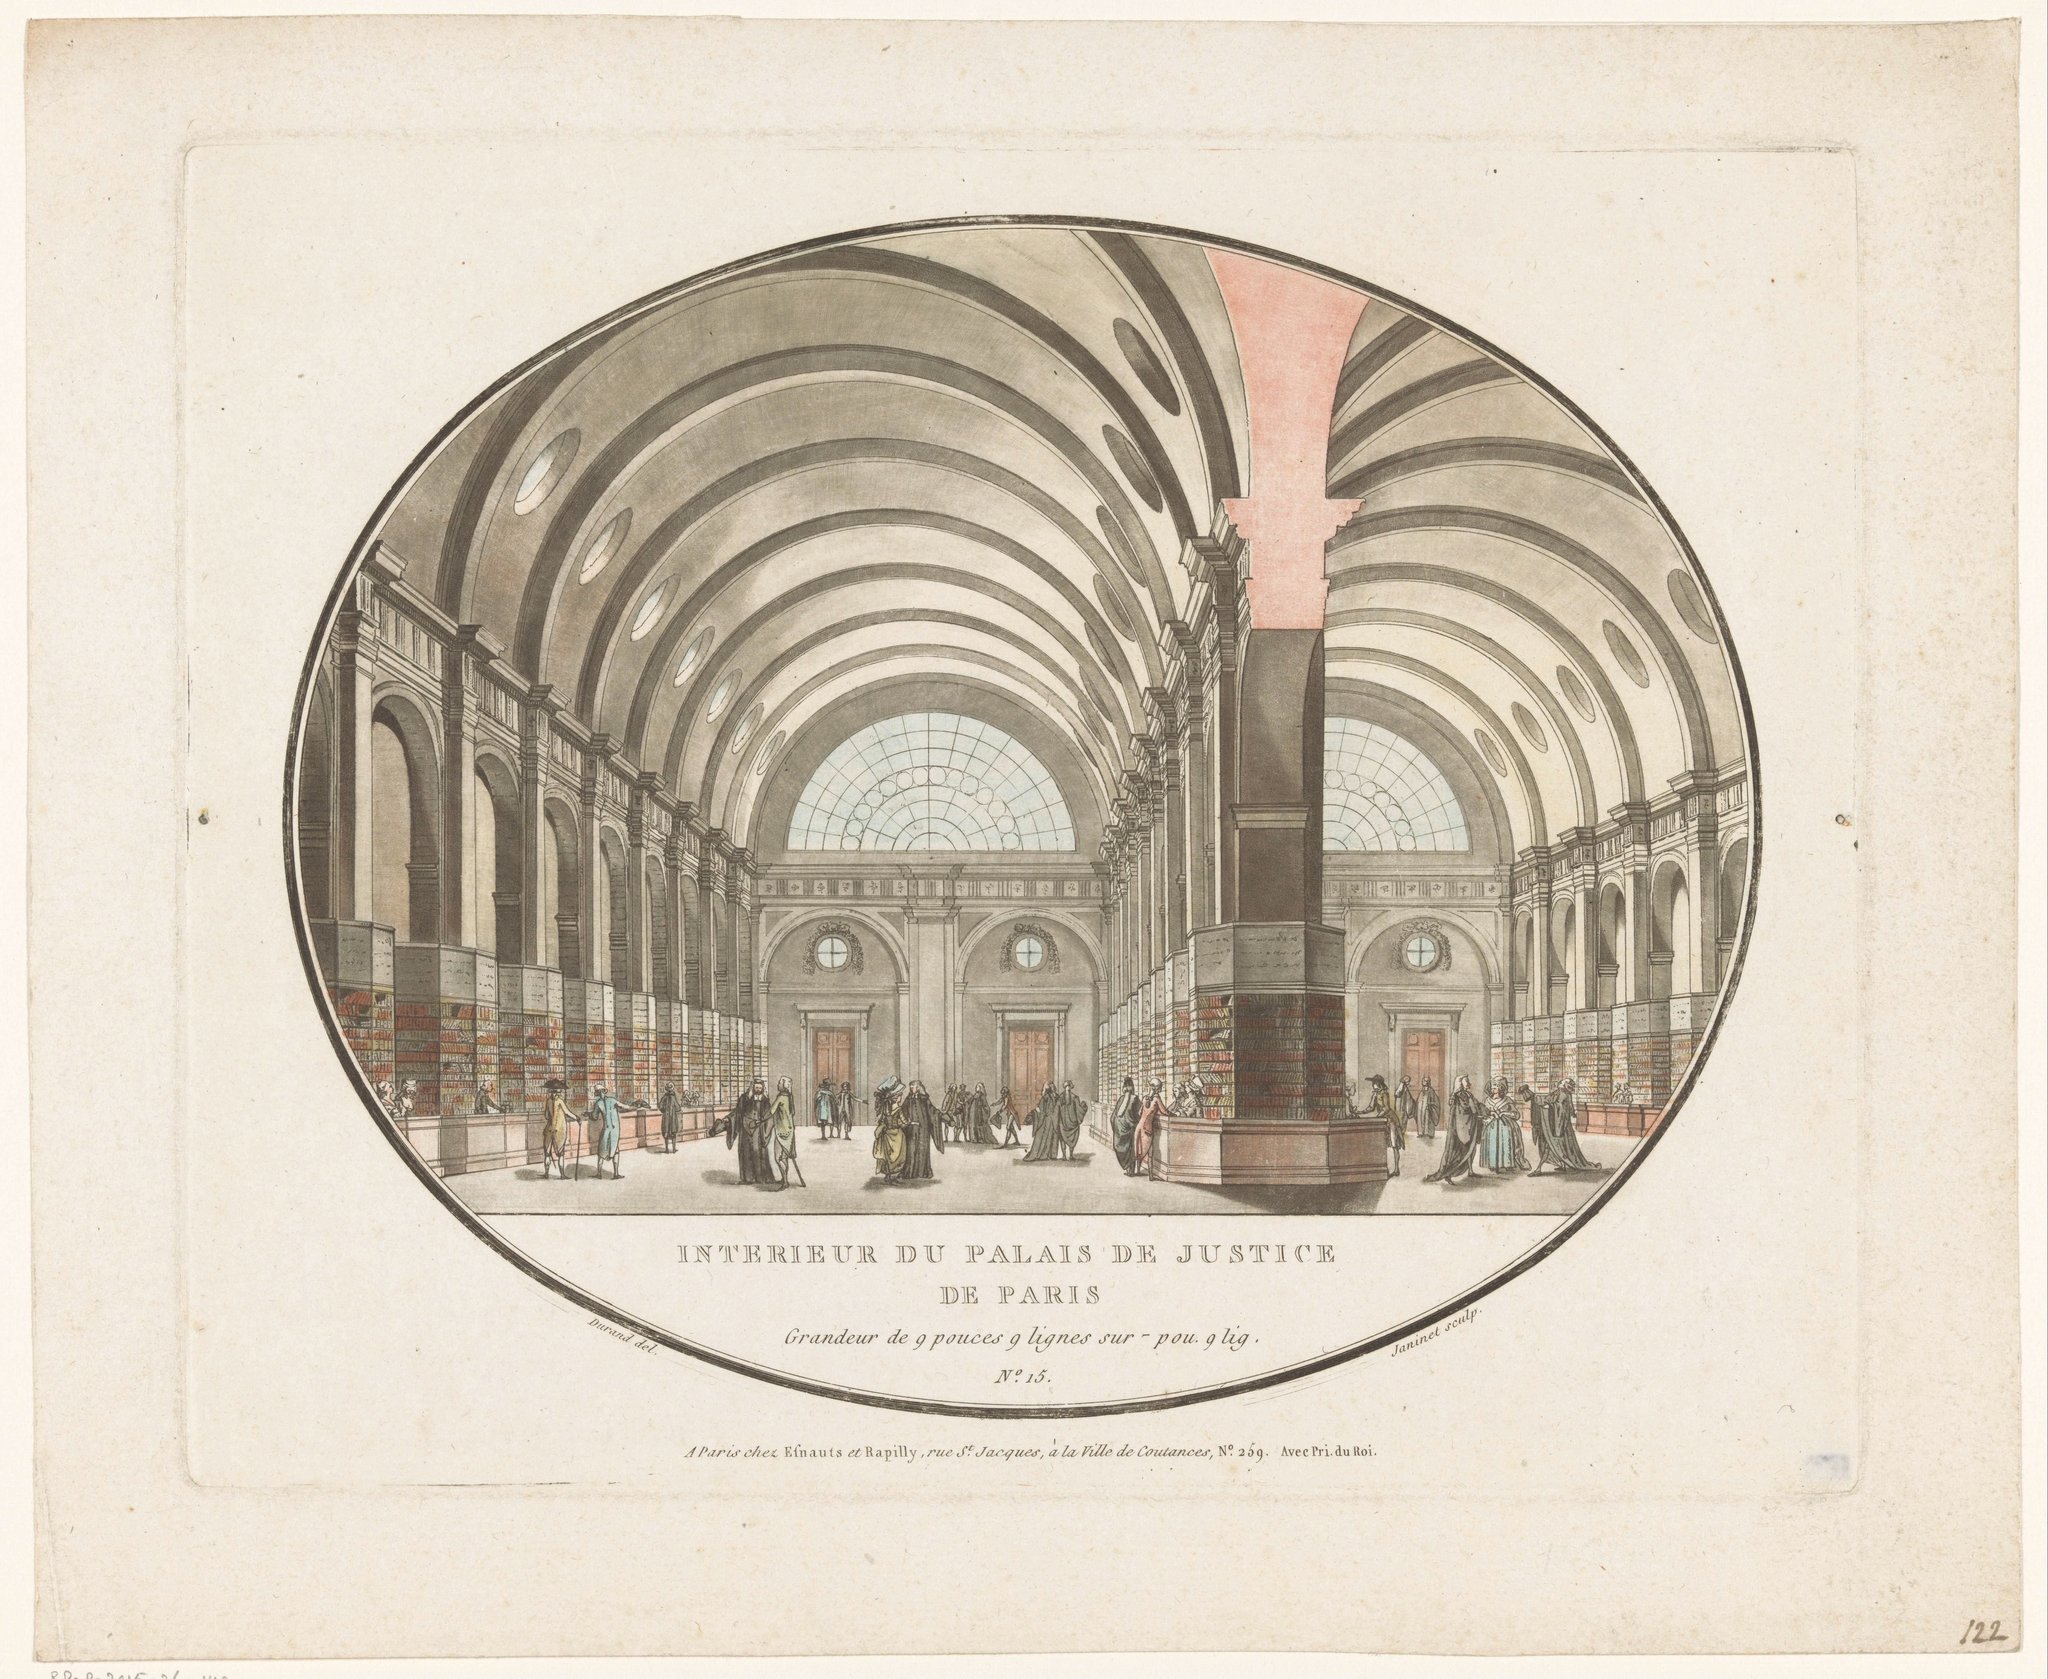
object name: print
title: Interieur van het Paleis van Justitie te Parijs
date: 1787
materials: paper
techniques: etching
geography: paris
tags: palace, book-shop, bookseller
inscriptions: collector's mark: Lugt 4780, number: ‘122’, collector's mark: Lugt 2228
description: Interieur van het Paleis van Justitie met boekhandels rond de pilaren. Onder de bezoekers bevinden zich verschillende juristen in toga.